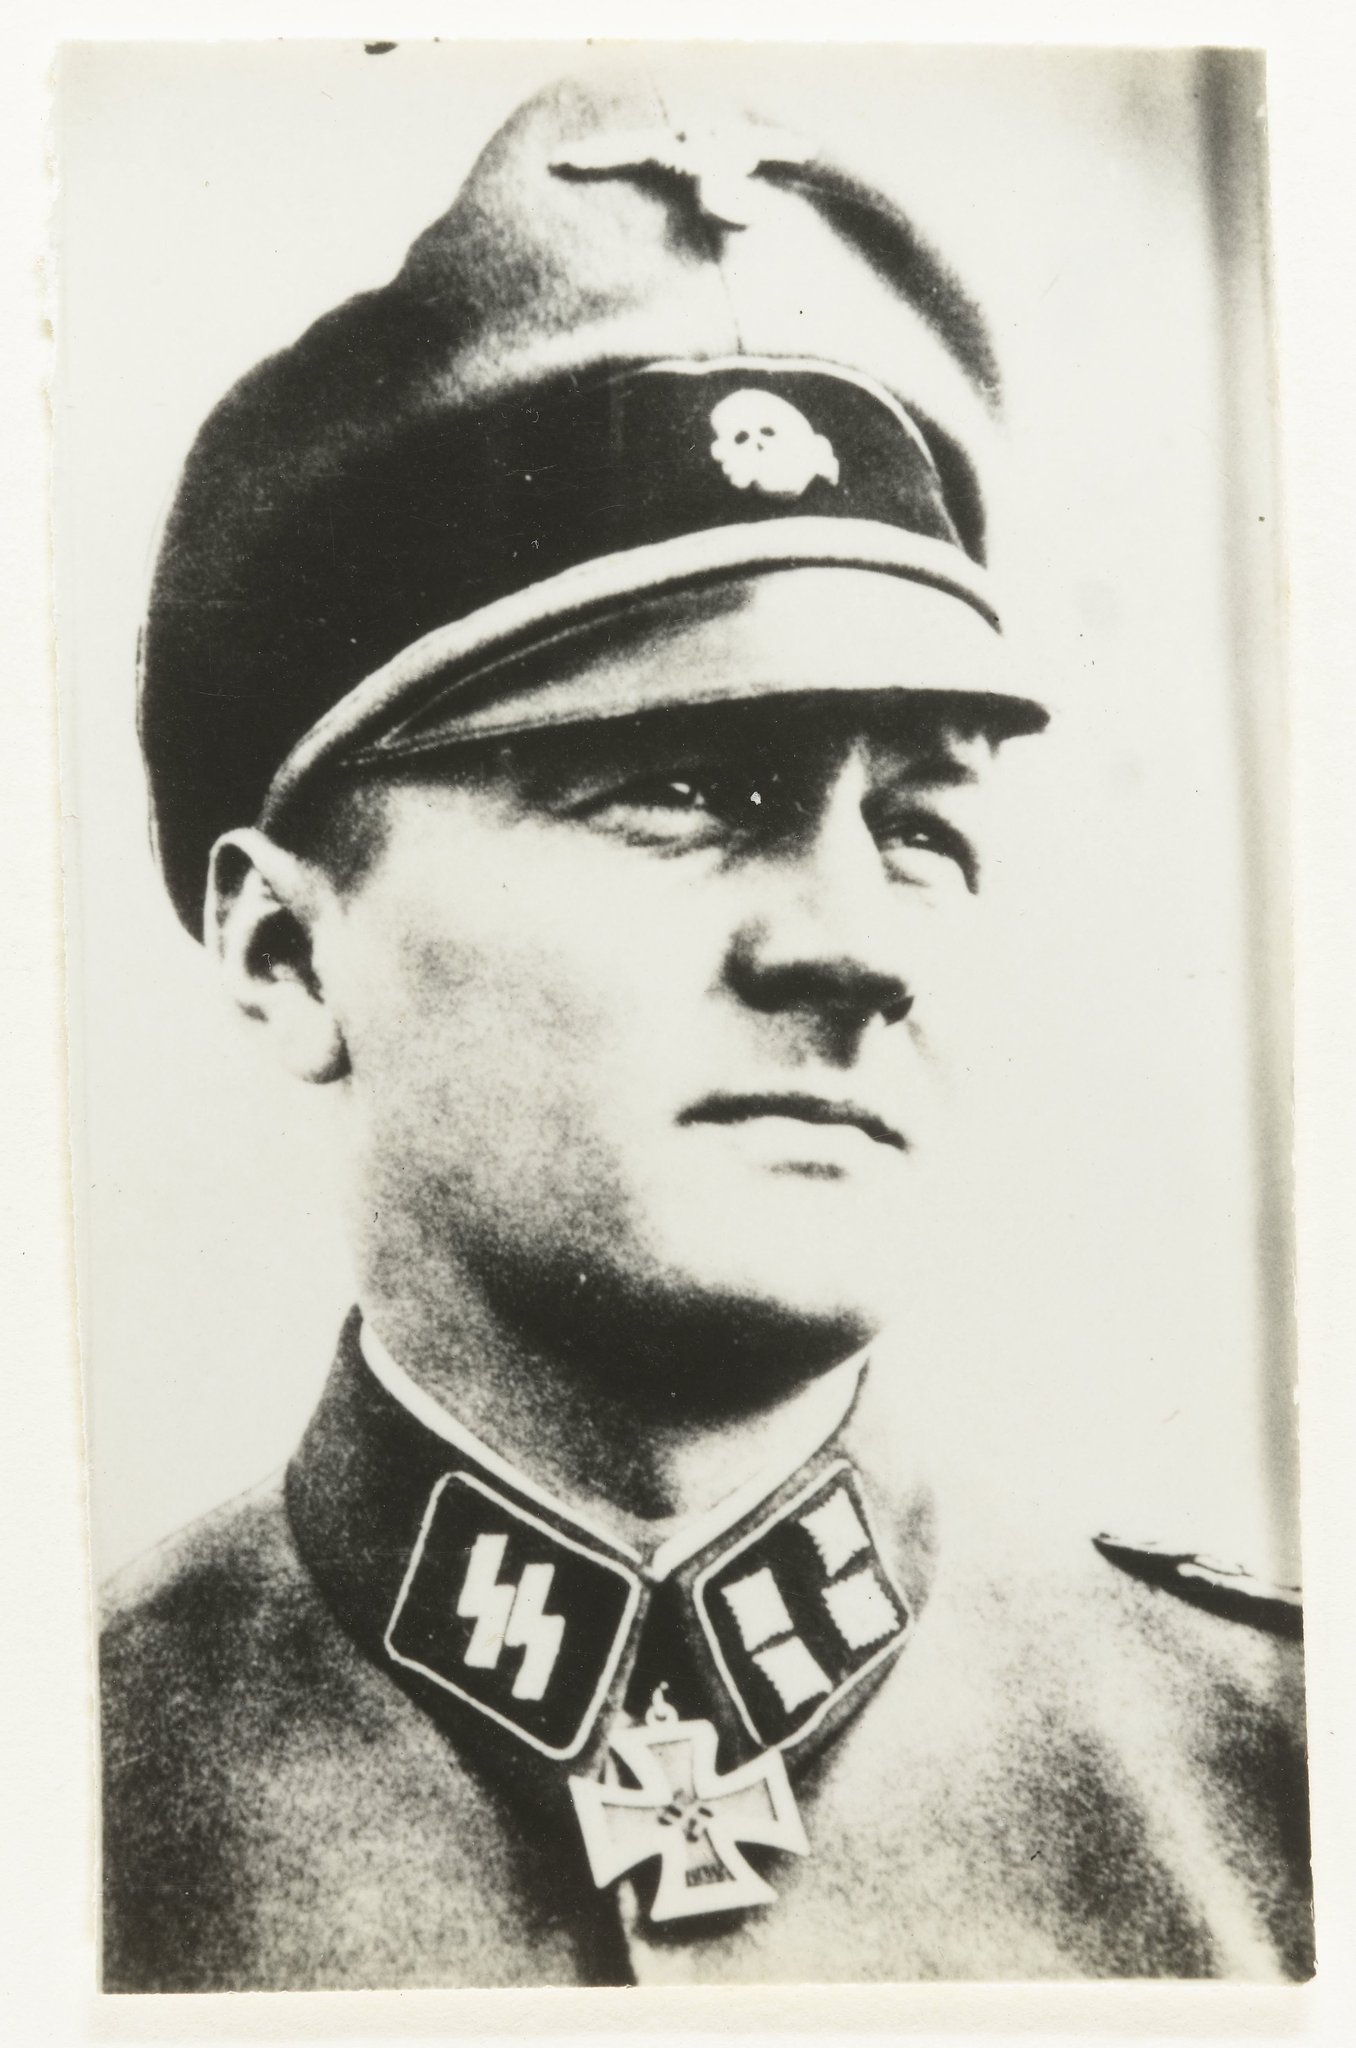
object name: contact print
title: Portret van een lid van de SS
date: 1942-1944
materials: photographic support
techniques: photography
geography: netherlands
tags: anonymous historical person portrayed, netherlands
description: Portret van een Duitse SSer. Op zijn kraag SS, op zijn pet het symbool van de Totenkopf-divisie. Om zijn hals hangt een Ritterkreuz, een hoge onderscheiding.